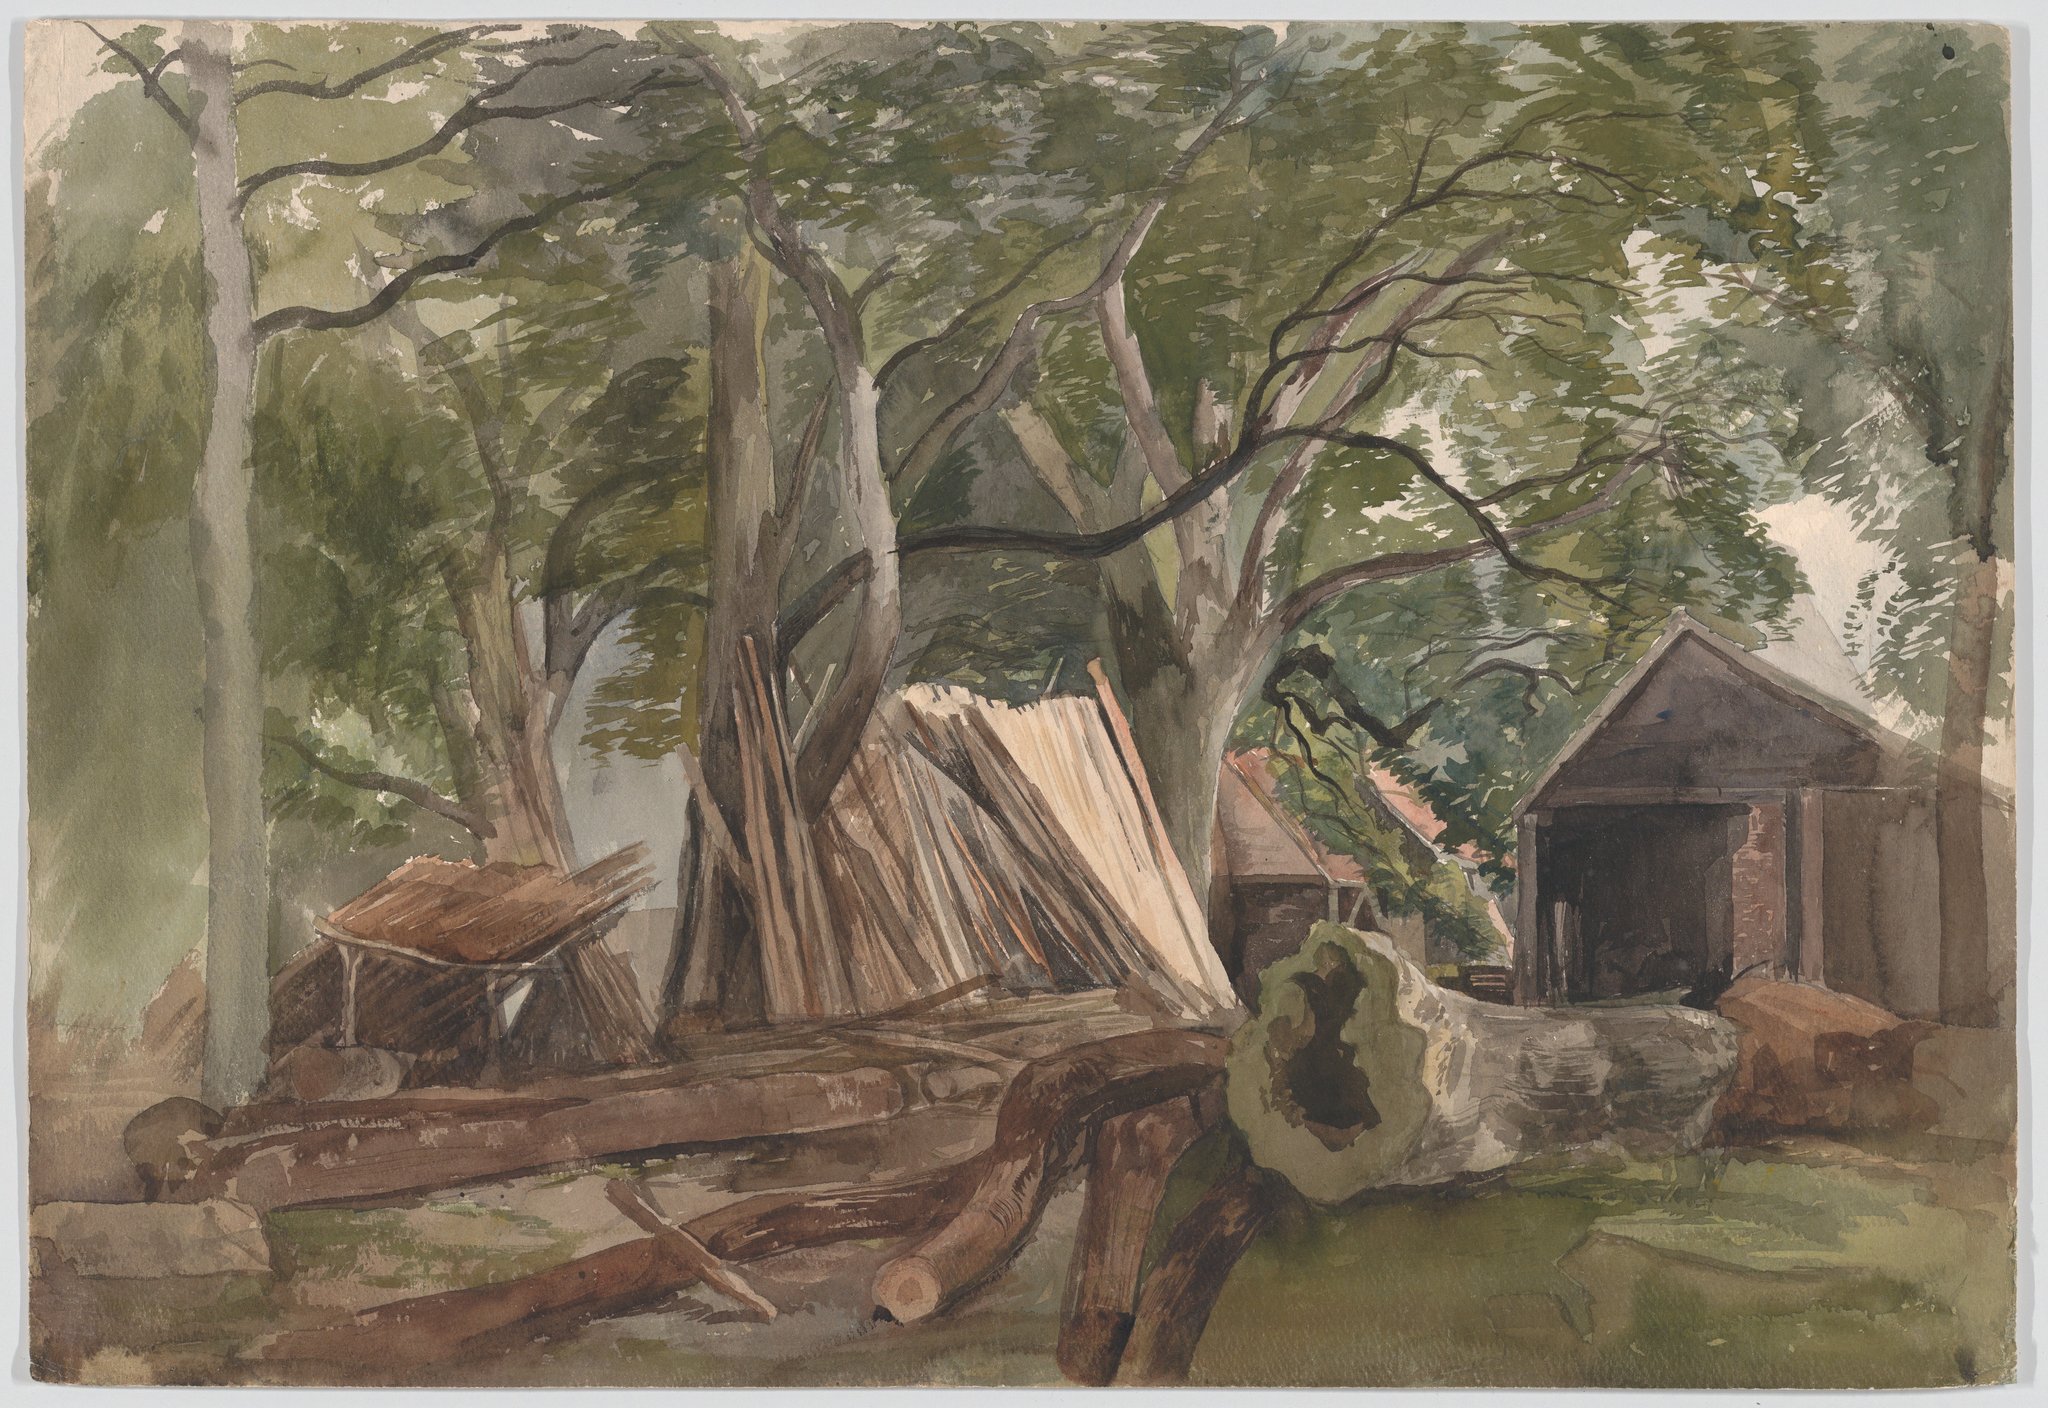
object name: drawing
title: Clearing with a lumber mill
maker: john middleton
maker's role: artist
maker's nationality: british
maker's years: 1827-1856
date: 1847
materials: graphite, watercolor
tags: factories,trees